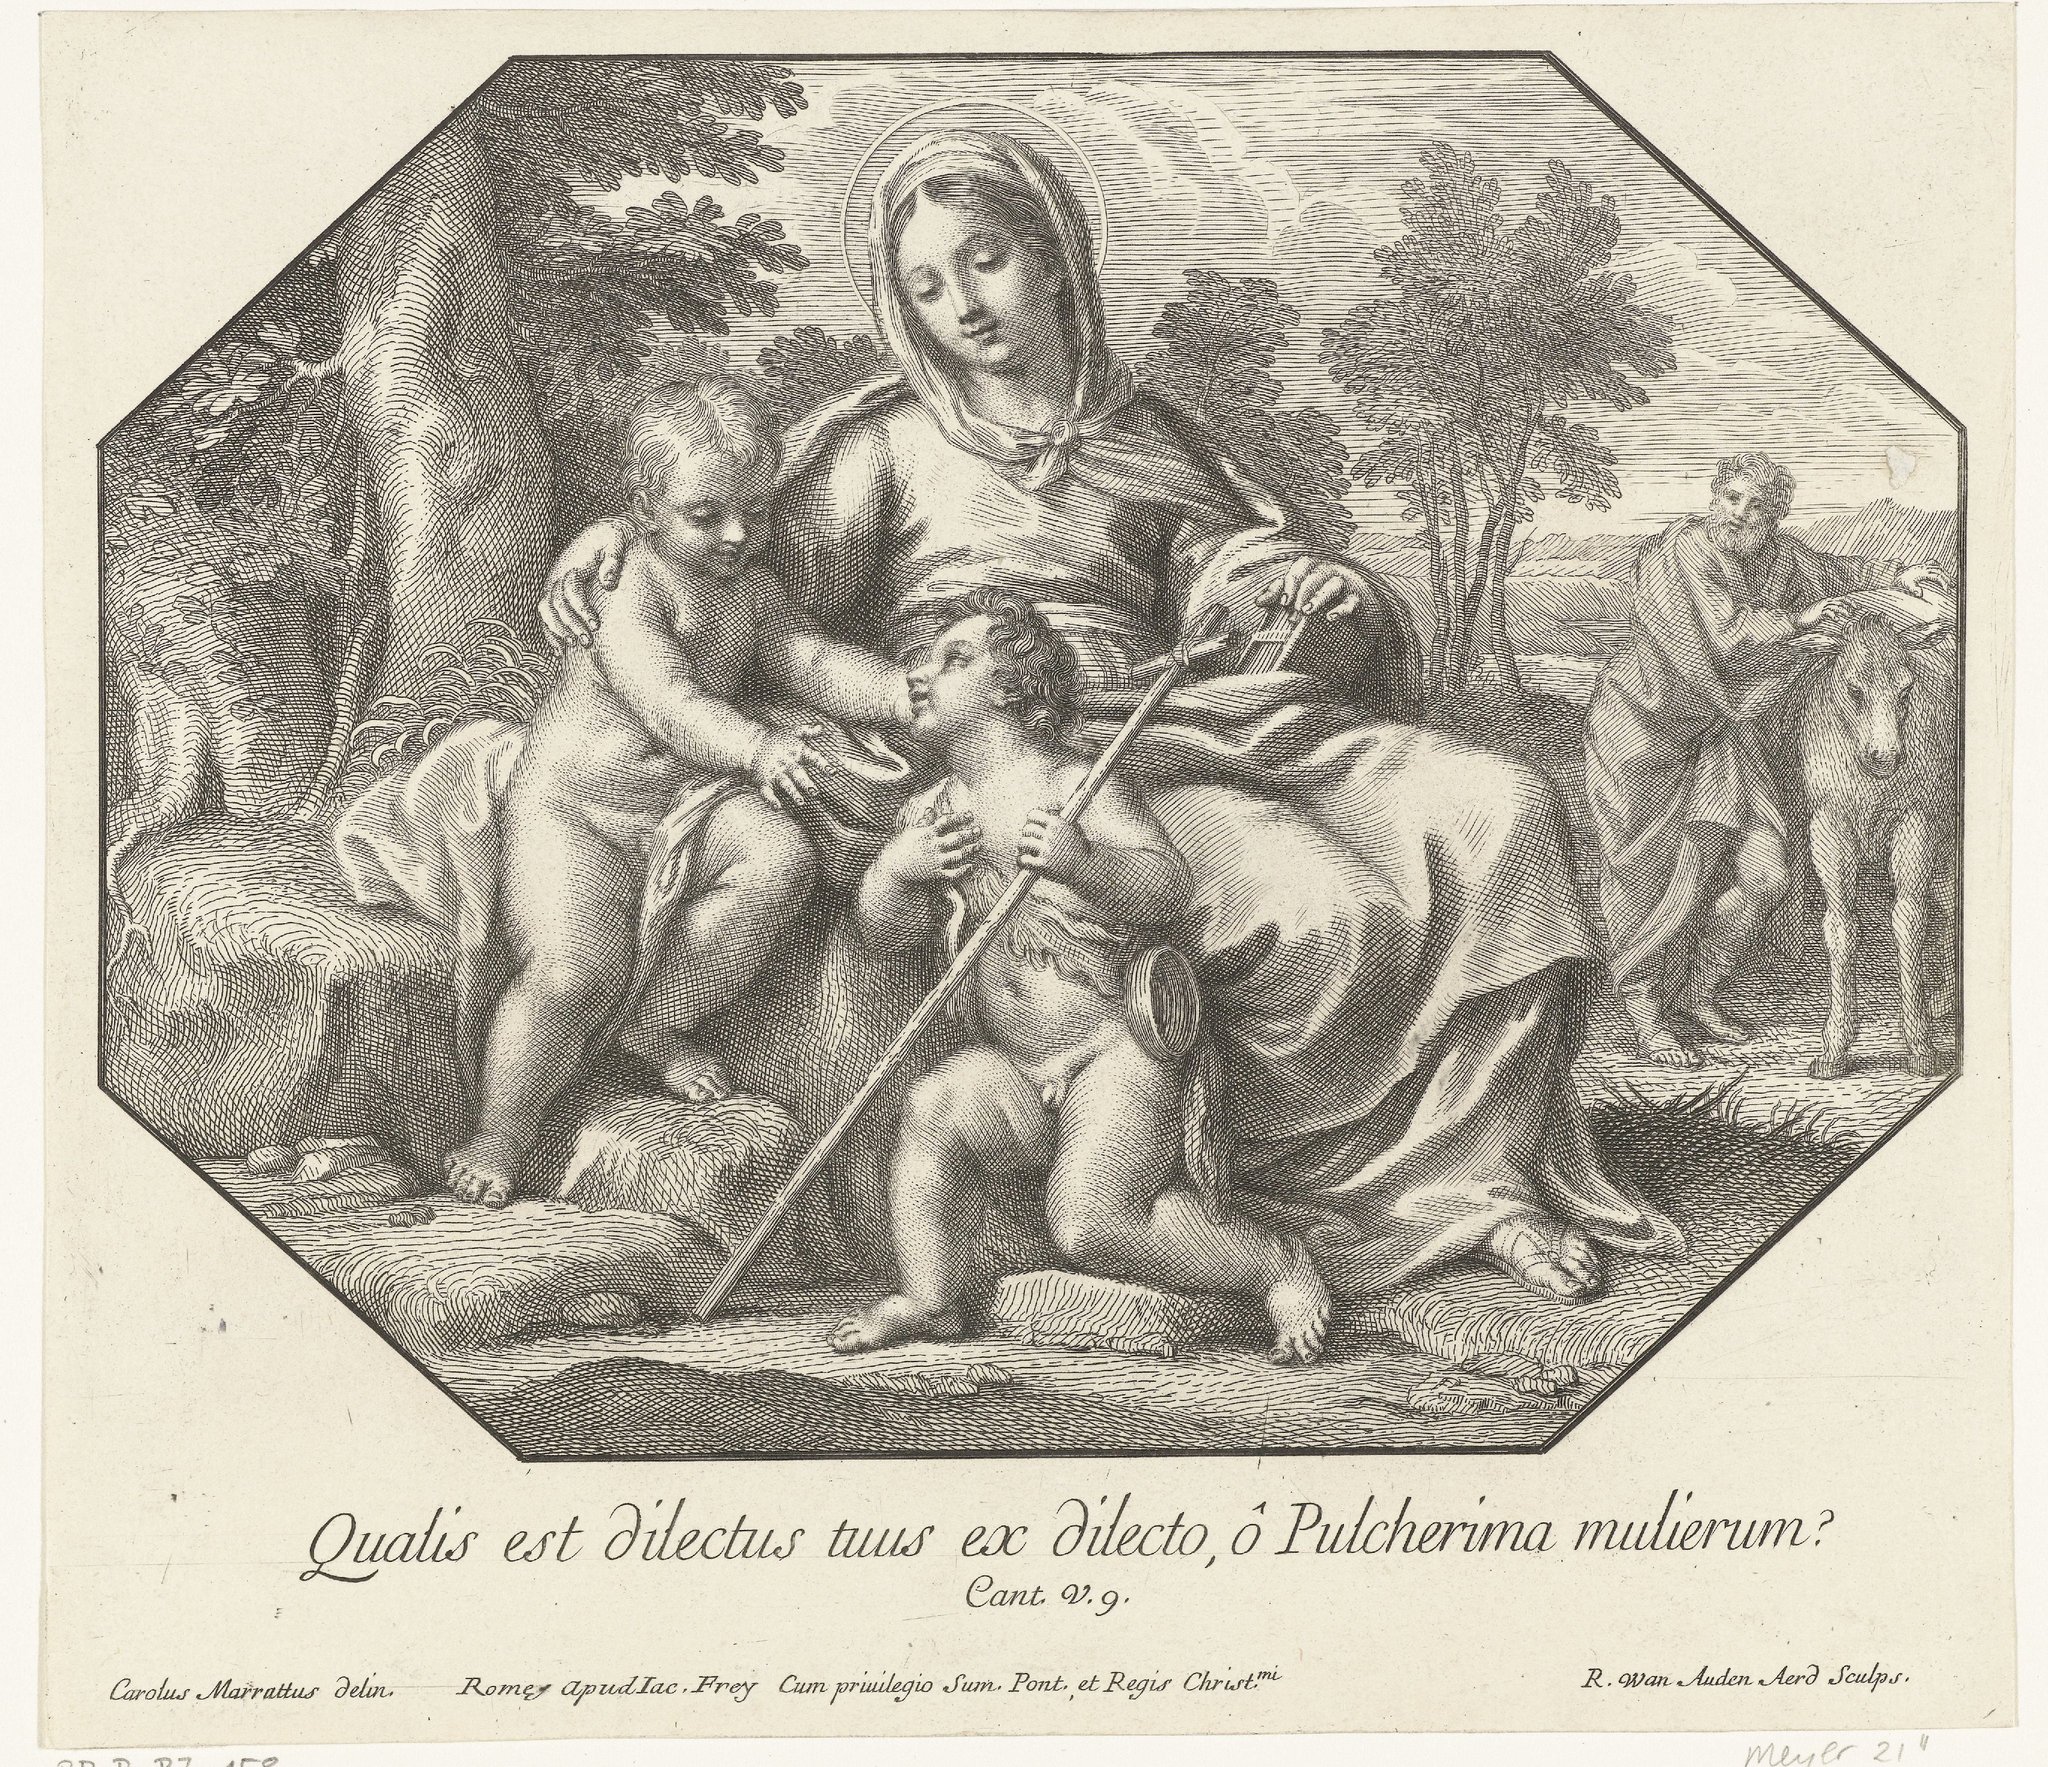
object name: print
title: Rest on the Flight into Egypt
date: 1685-1723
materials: paper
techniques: engraving, etching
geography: rome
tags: rest on the flight into egypt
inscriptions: collector's mark: Lugt 2228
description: Maria zit met Christus en Johannes de Doper onder een boom te rusten. Johannes houdt een houten kruis in zijn hand. Op de achtergrond staat Jozef bij de ezel. Onder de voorstelling een vers in het Latijn.